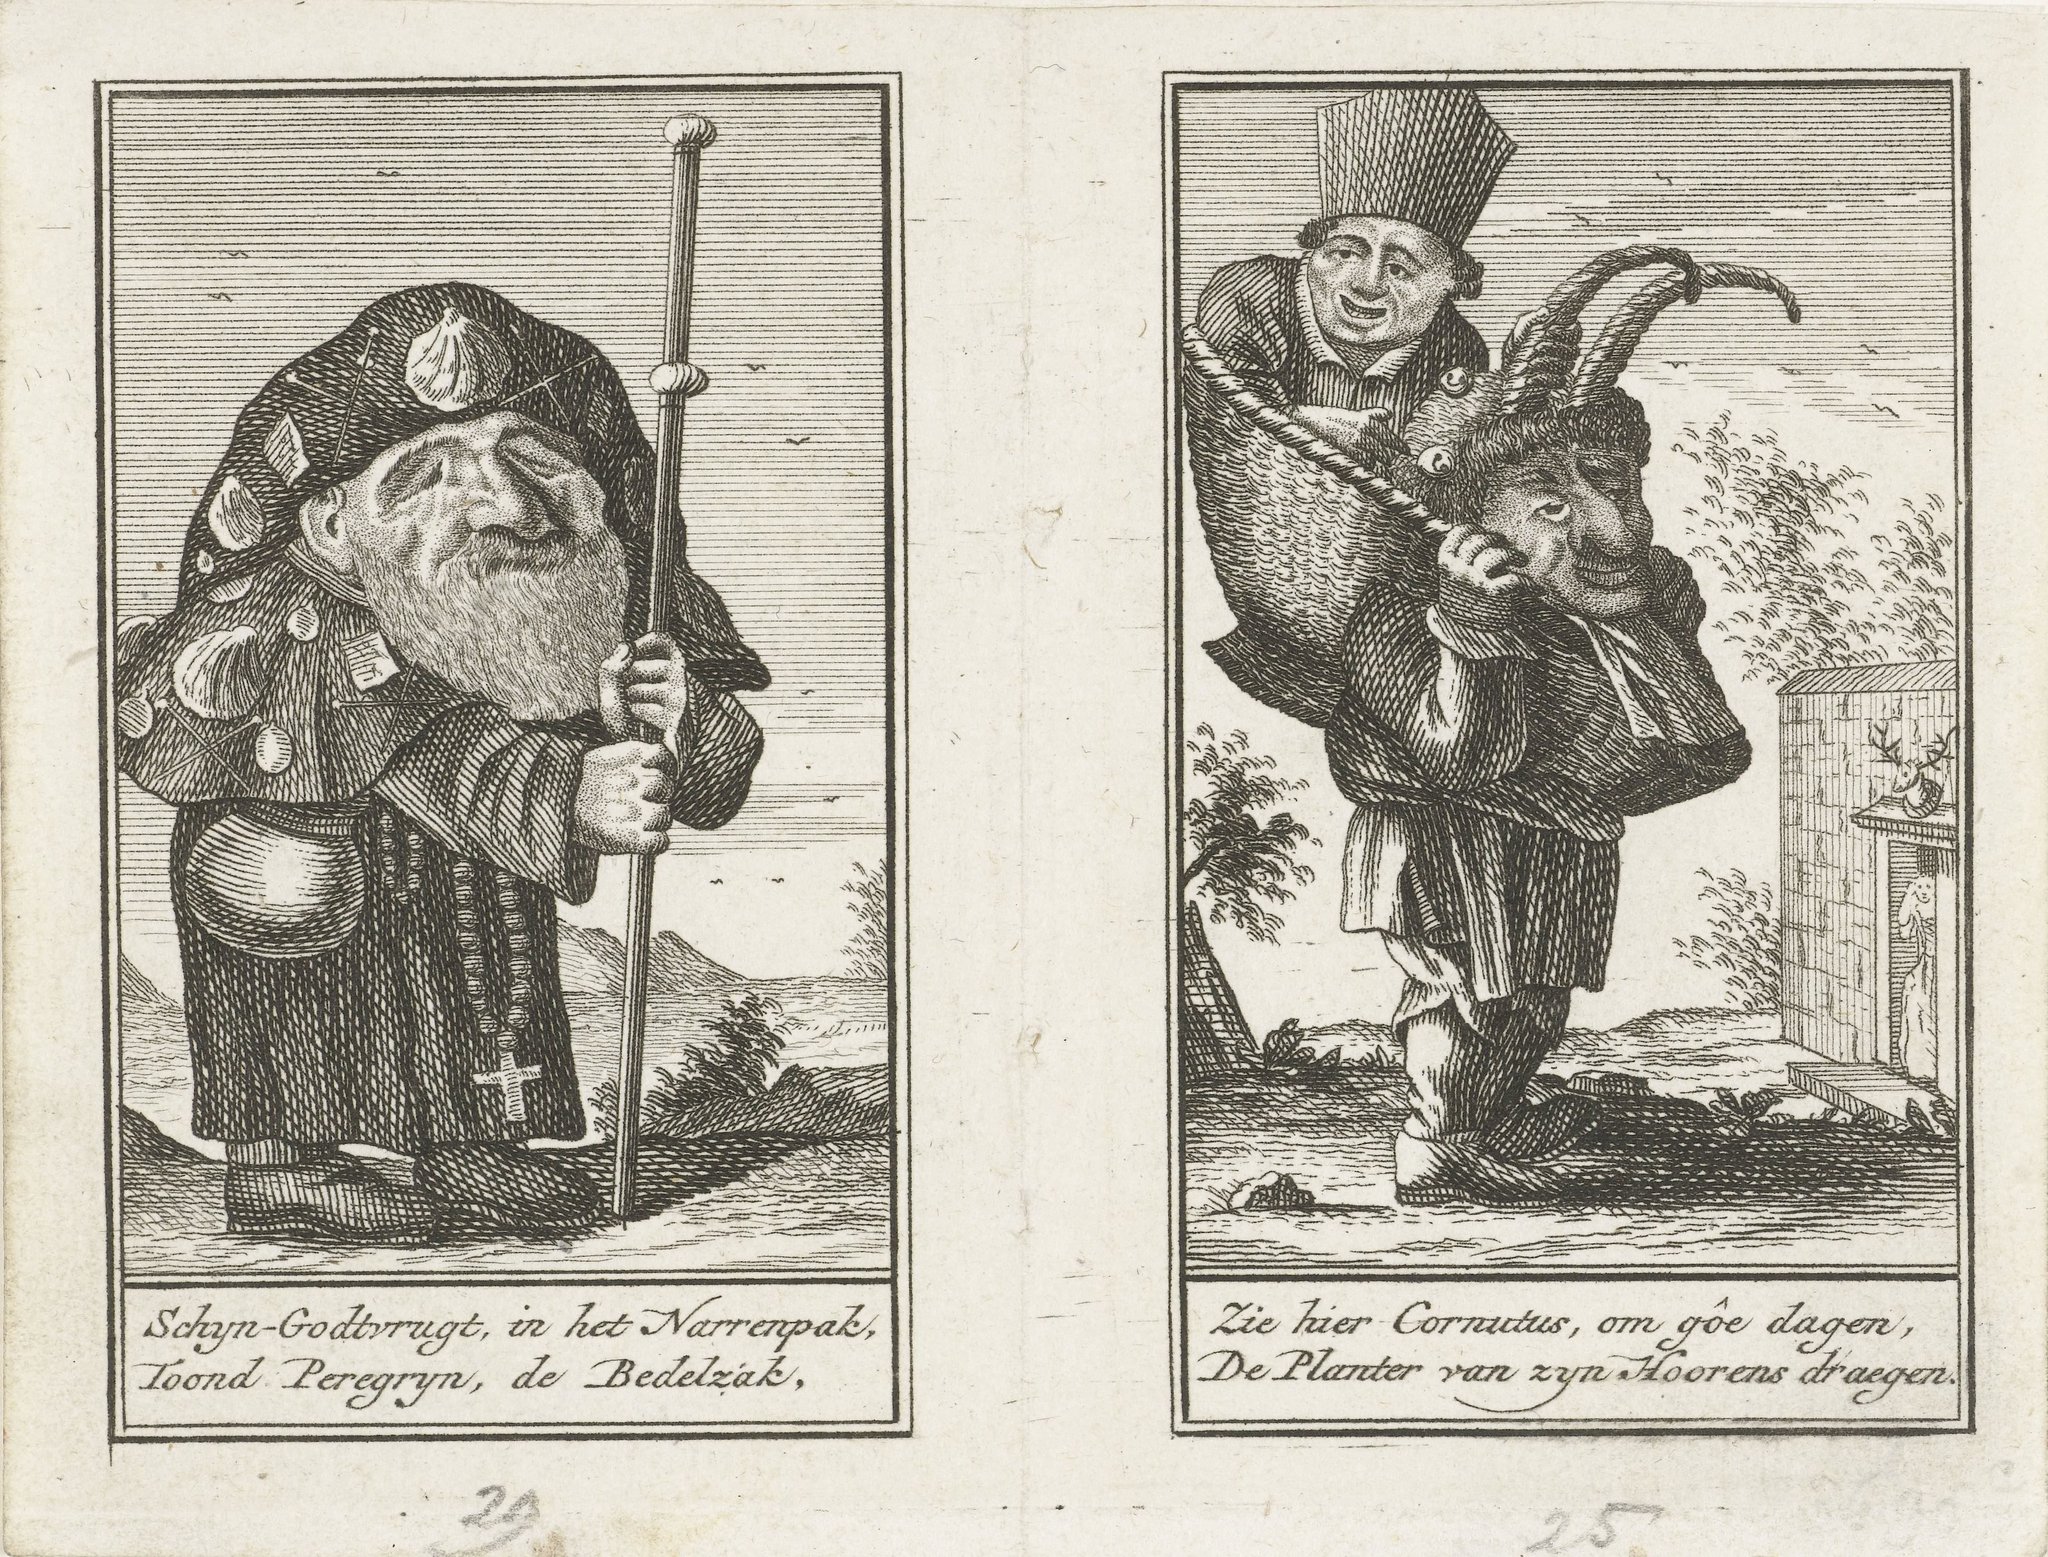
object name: print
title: Twee bladzijden met kleine mensen, ca. 1720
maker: Anonymous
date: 1770-1780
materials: paper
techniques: etching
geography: northern netherlands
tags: caricatures (human types), little people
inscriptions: collector's mark: Lugt 2228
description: Twee bladzijden met de kleine mensen Peregryn en Cornutus, ca. 1720. Afkomstig uit een uitgave van ca. 1775 met verkleinde kopieën naar de oorspronkelijke Nederlandse serie met karikaturen van kleine mensen uit 1716, bekend als Het Dwergentooneel.